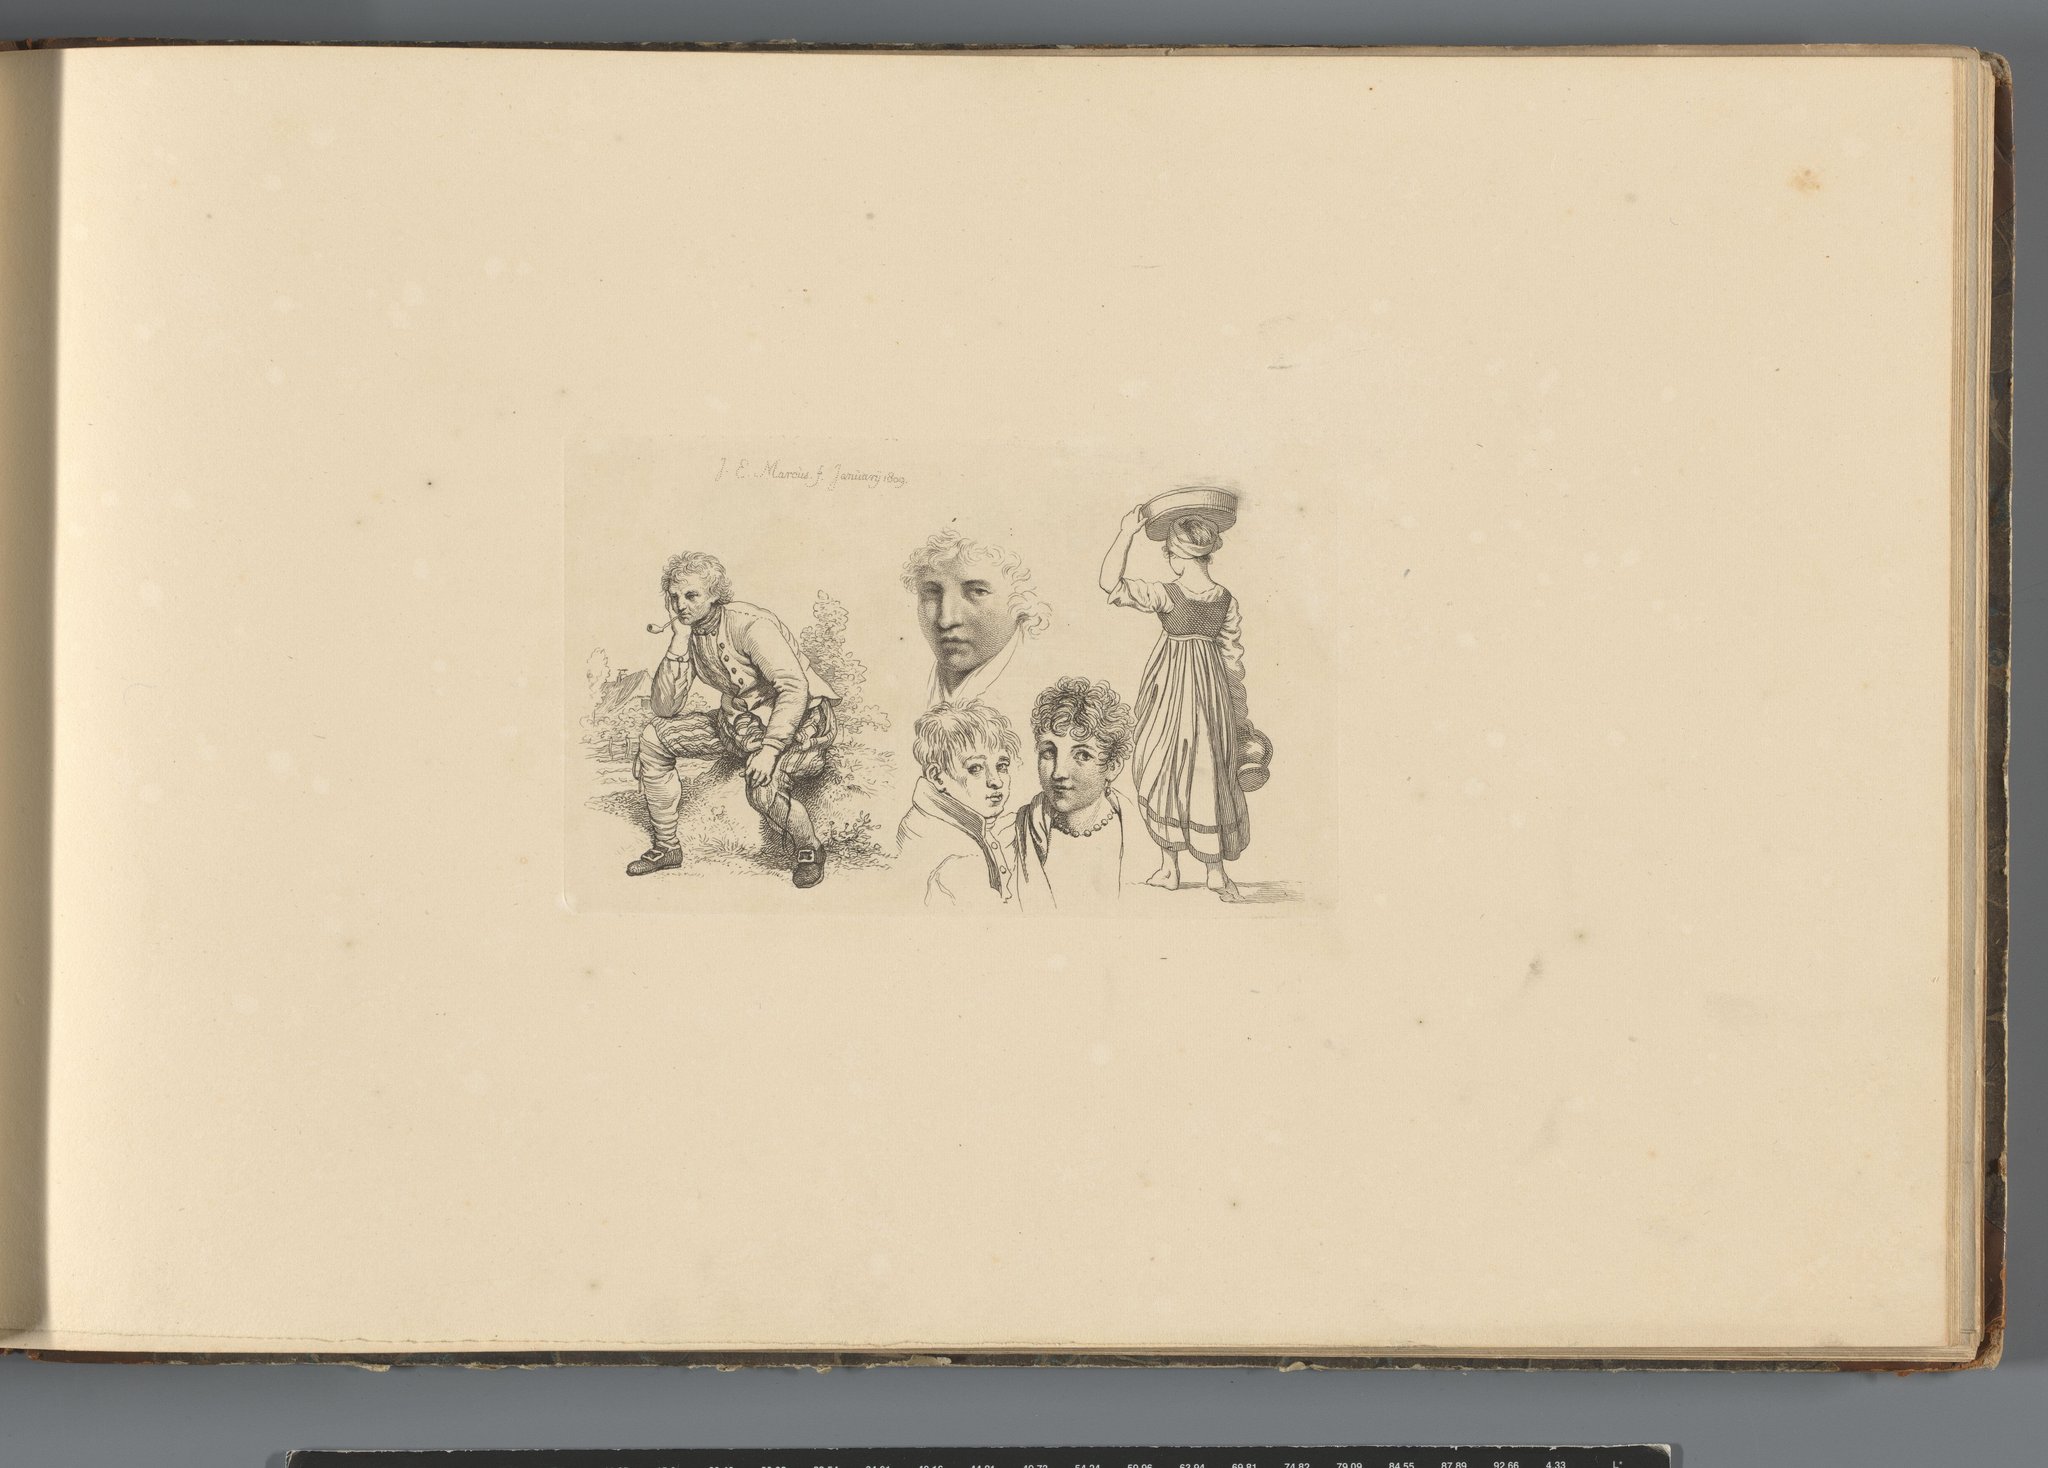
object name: album leaf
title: Studieblad met twee figuren en drie gezichten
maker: jacob ernst marcus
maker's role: draughtsman, print maker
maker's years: 1774-1826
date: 1801-1809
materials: paper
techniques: etching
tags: anonymous historical person portrayed, sitting on the ground, carrying something on the head or on the shoulders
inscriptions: date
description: Deze prent maakt deel uit van een album.